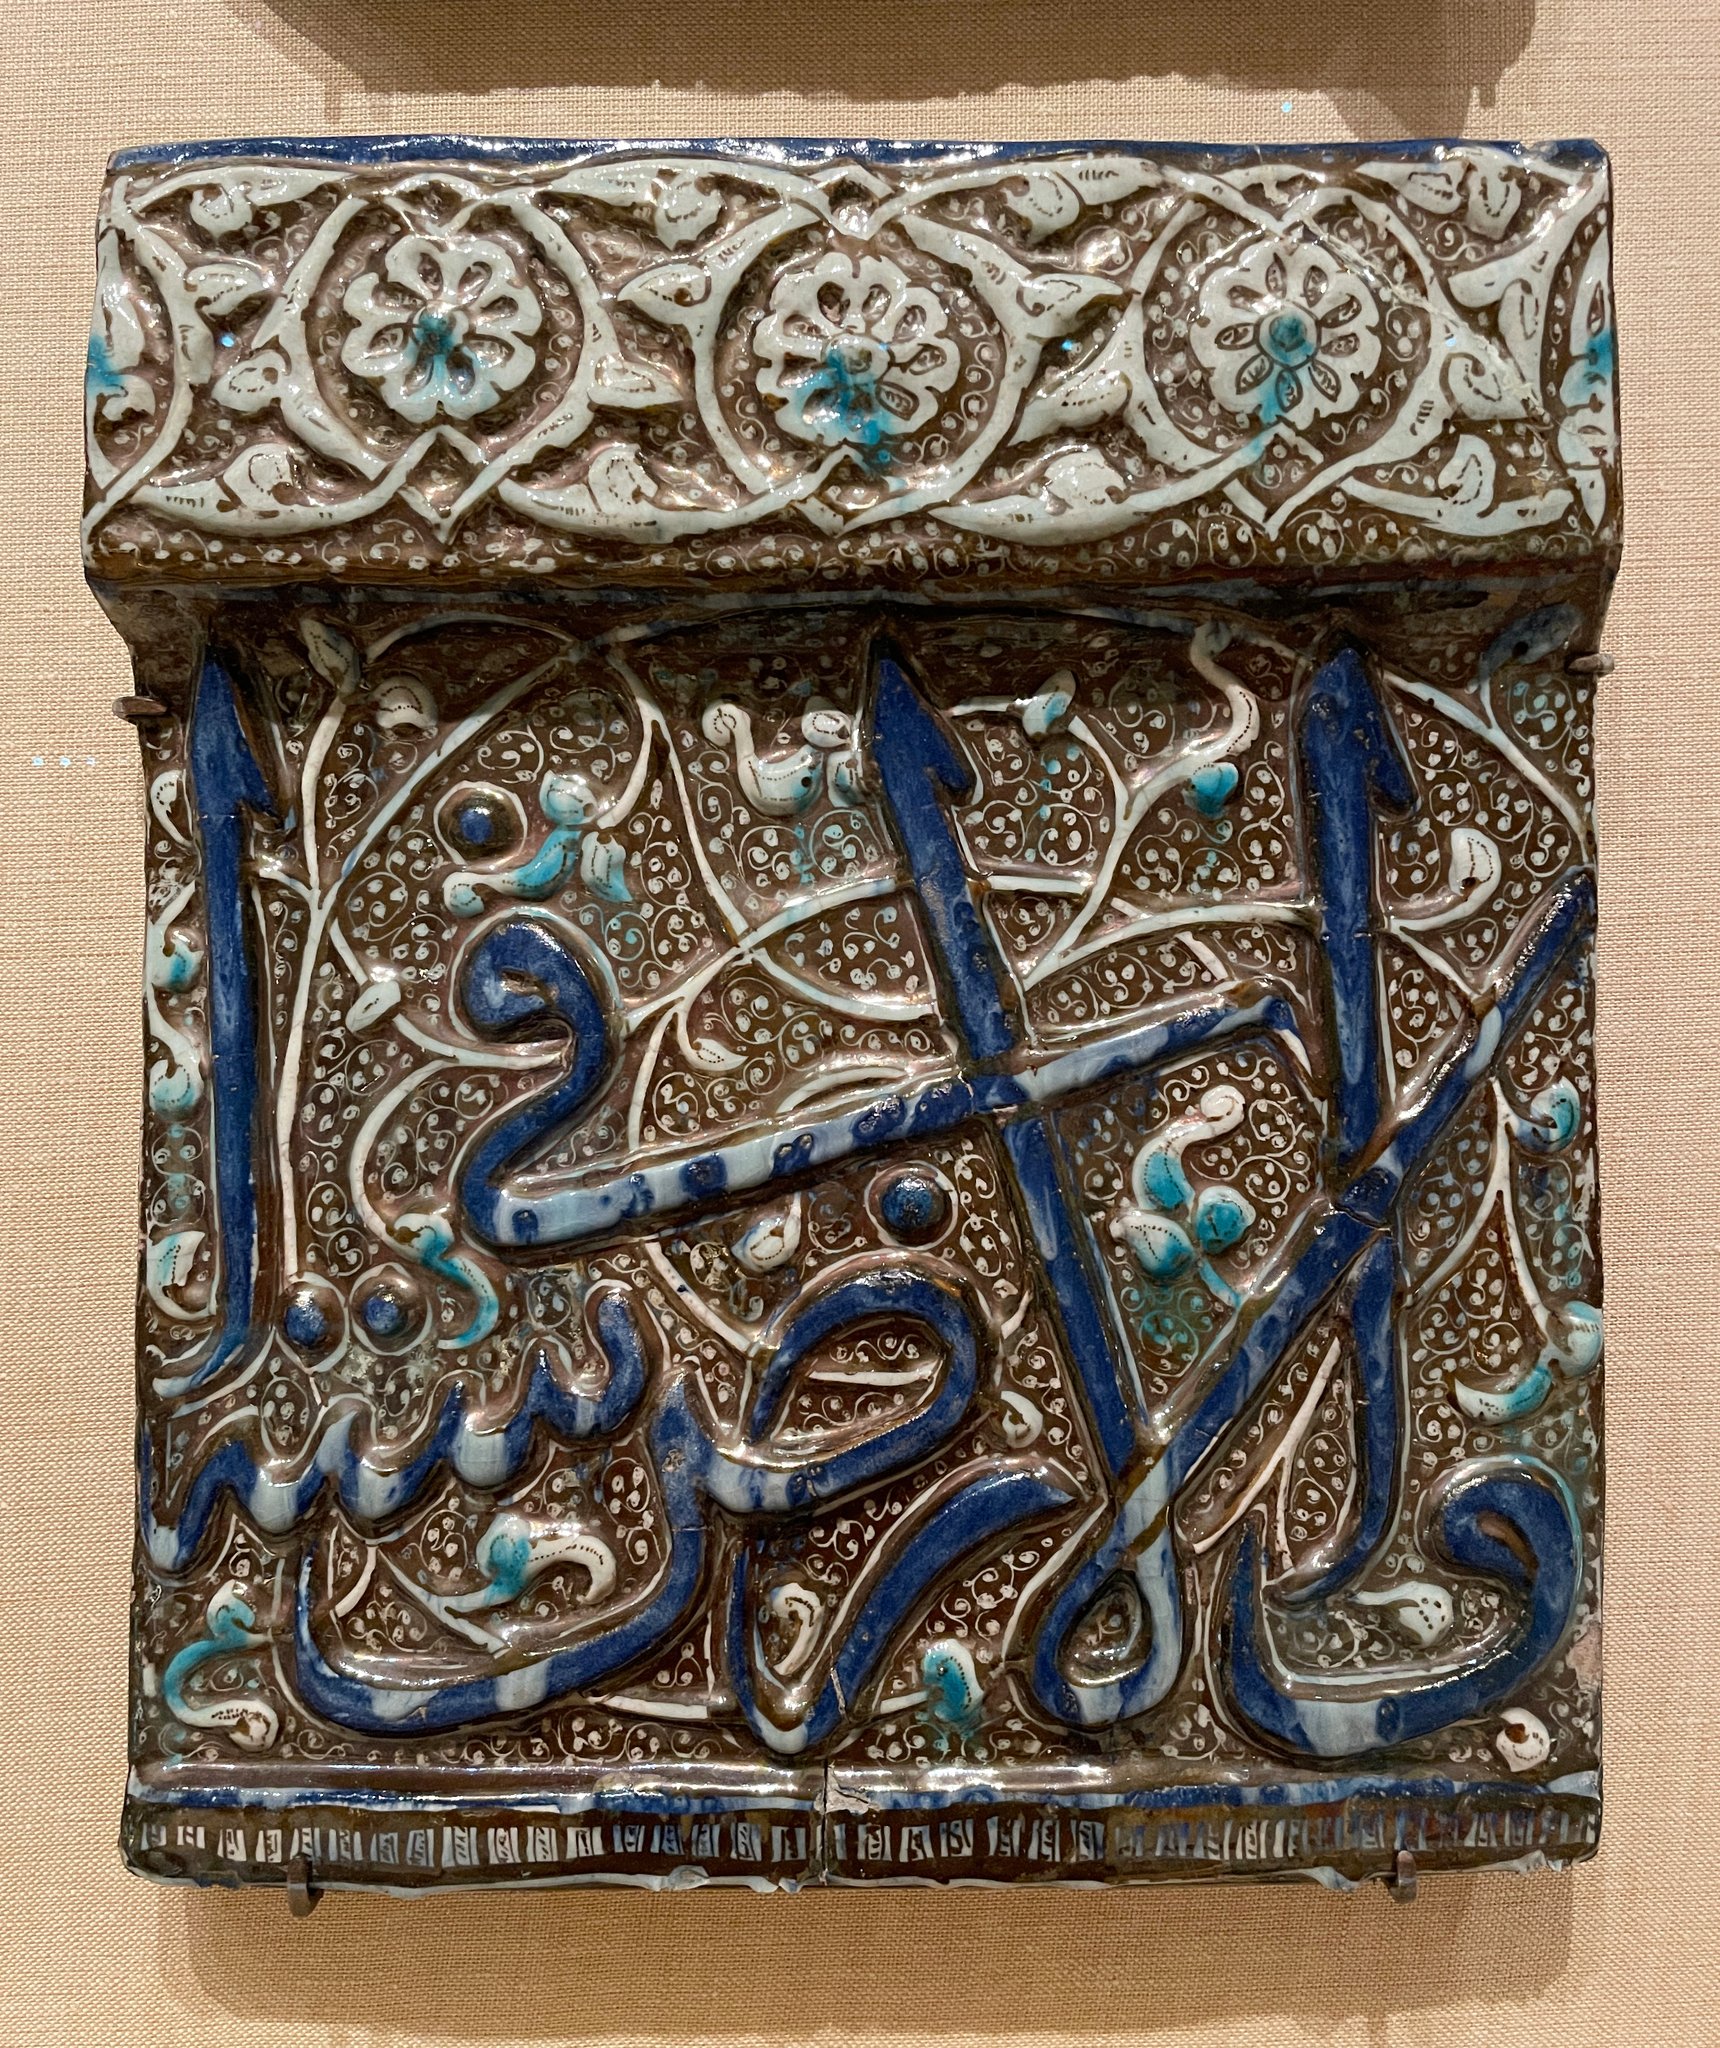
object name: tile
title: Tile from an Inscriptional Frieze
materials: glaze, stonepaste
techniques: luster painting, painting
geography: iran